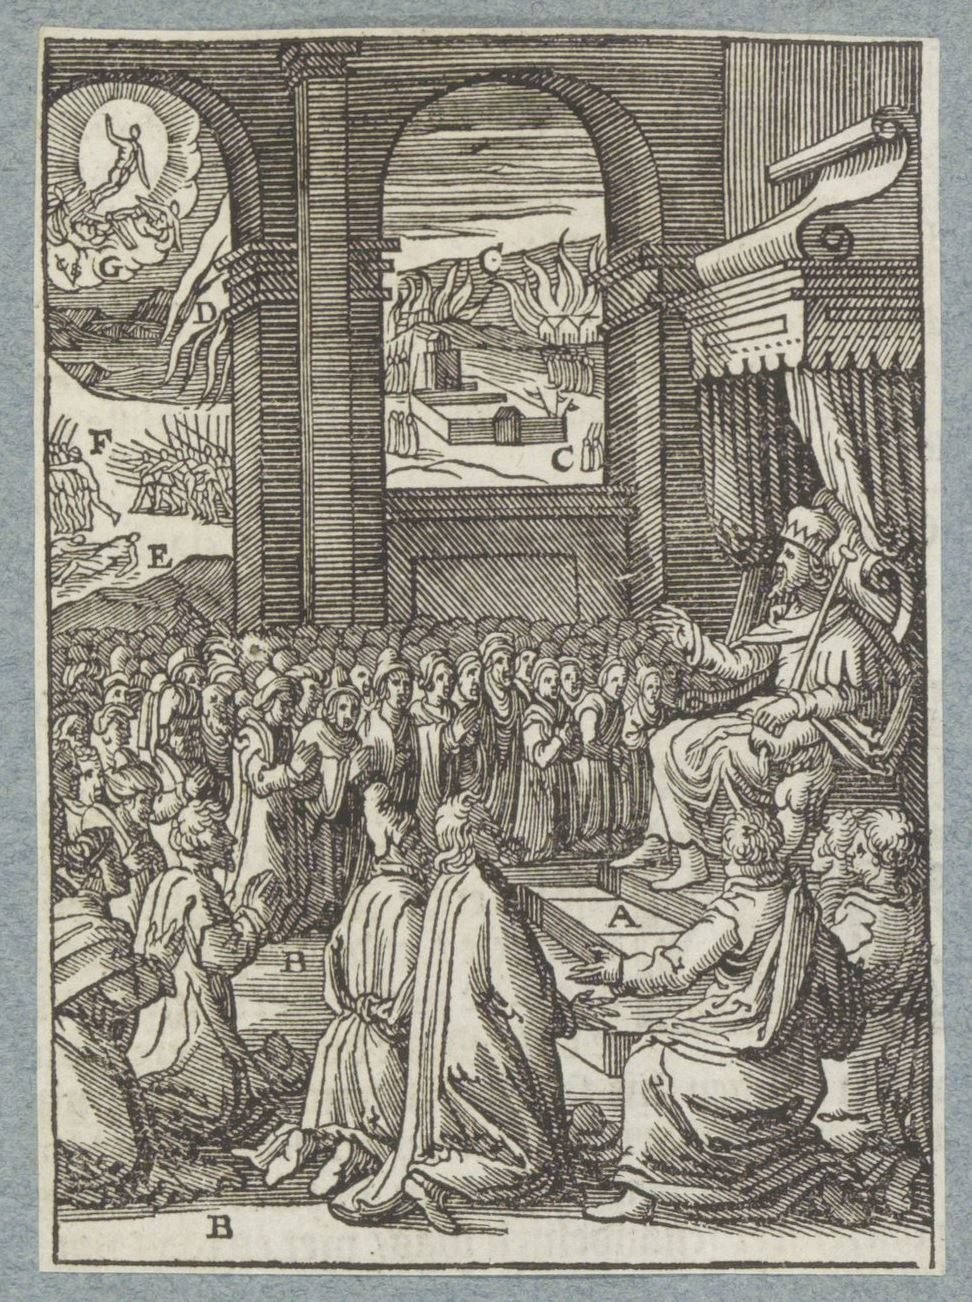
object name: album leaf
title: Valse messias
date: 1629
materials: paper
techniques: letterpress printing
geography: antwerp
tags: false messiah ~ jewish religion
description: De mensen uit Judea knielen in aanbidding voor een valse messias die in de tempel op een troon zit. Bij verschillende elementen uit de voorstelling staan letters. De prent maakt deel uit van een album.